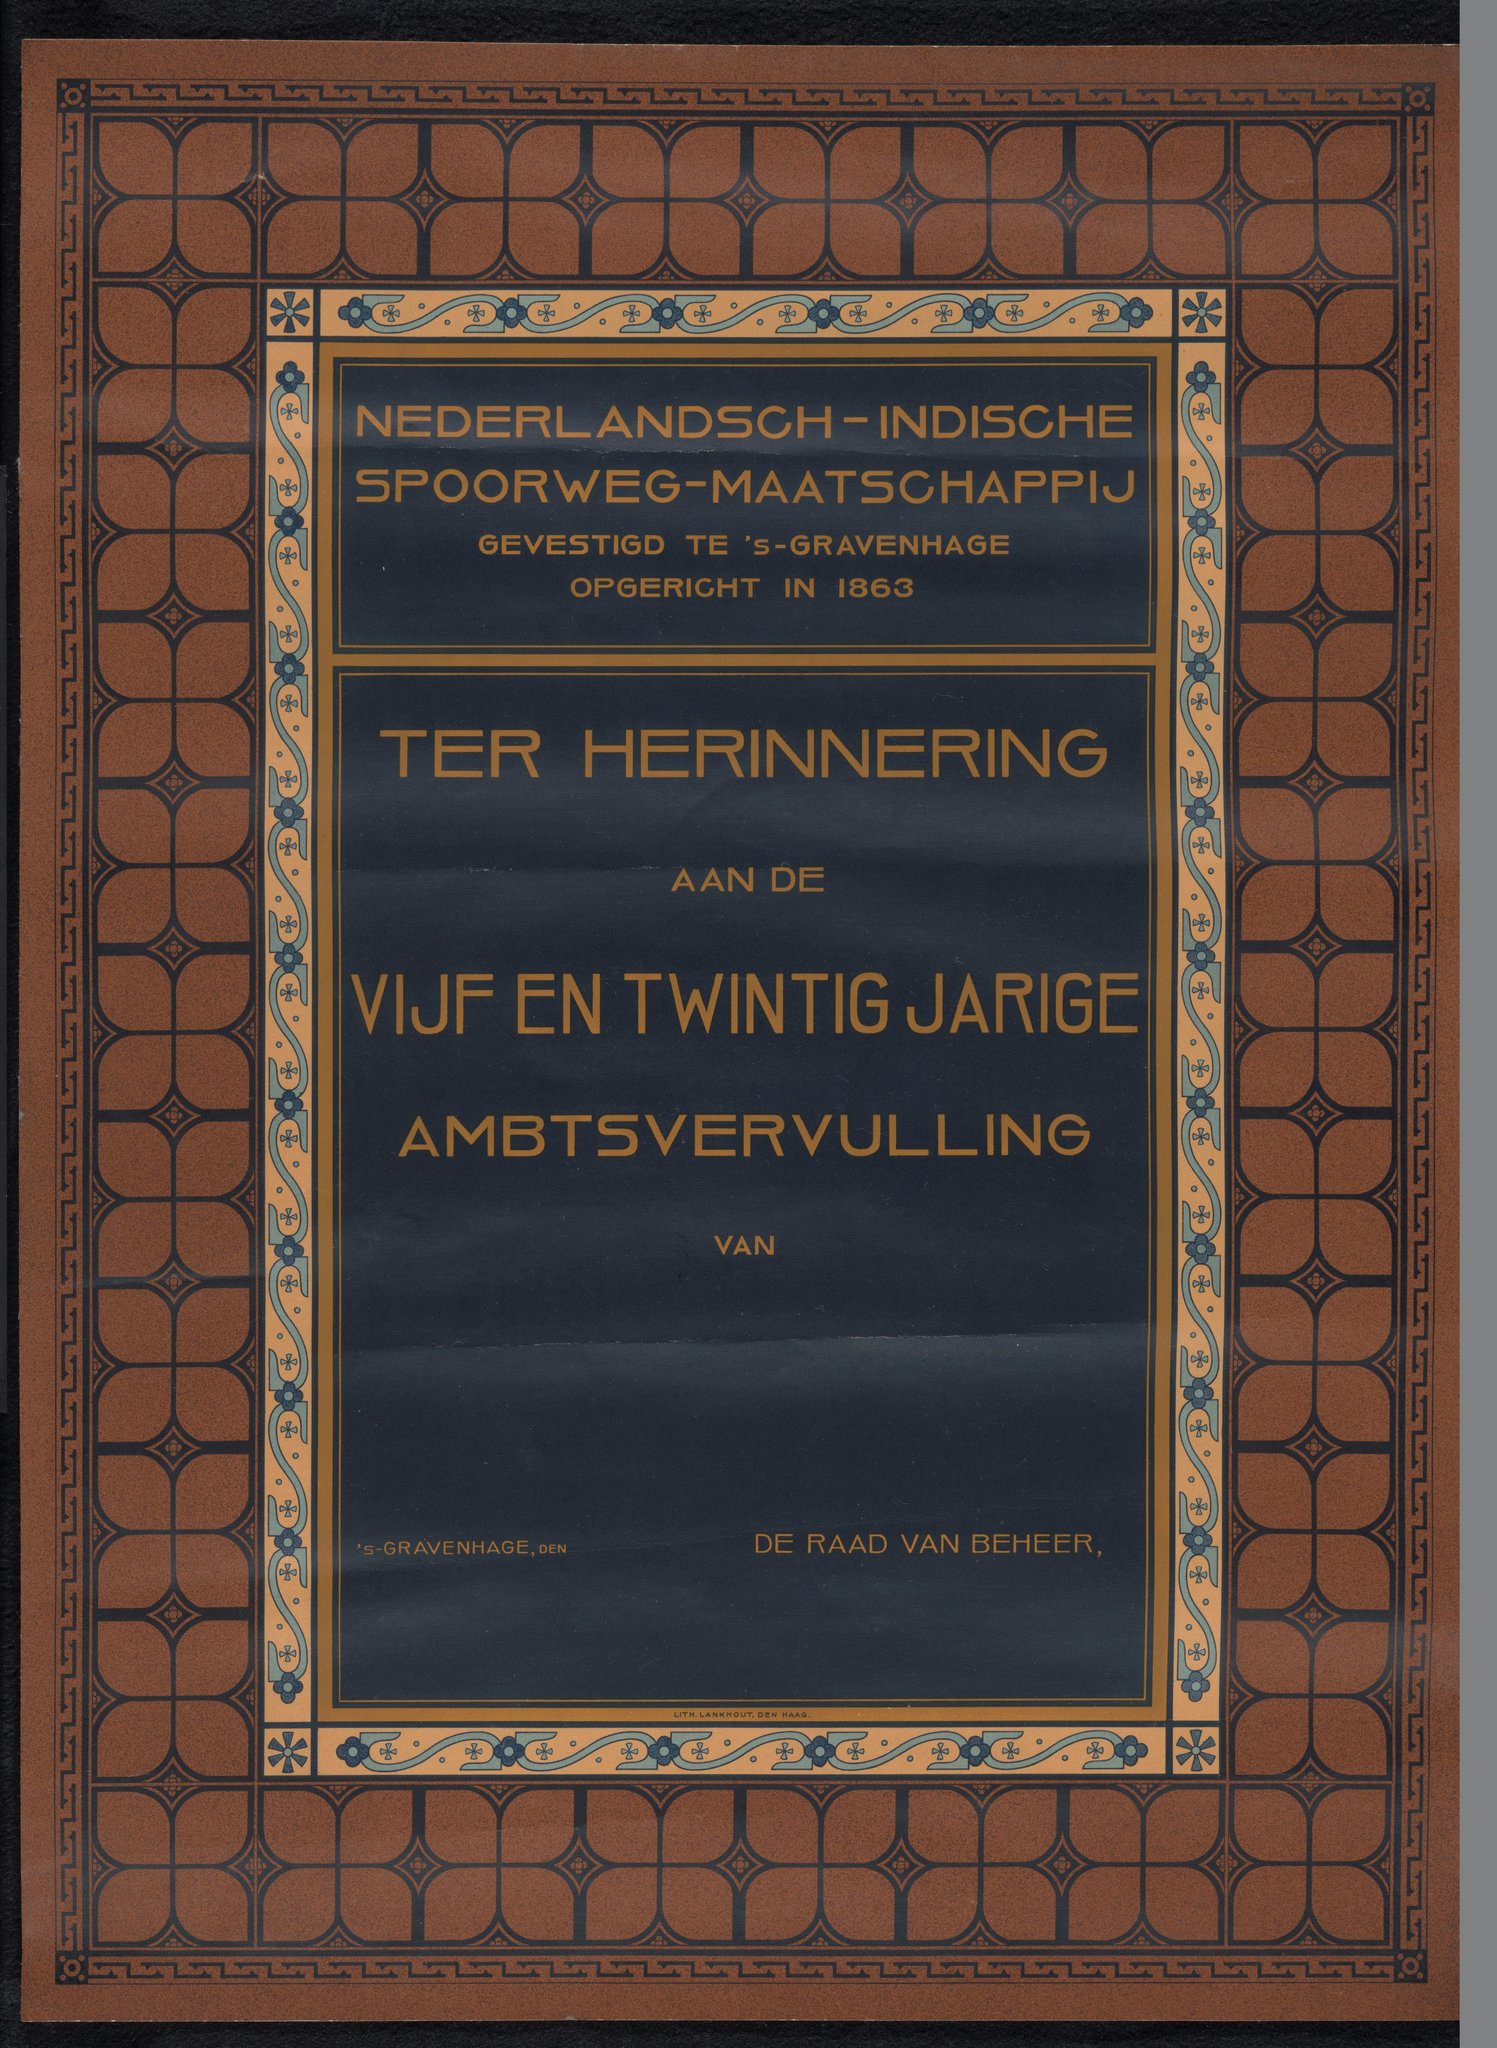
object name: charter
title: Oorkonde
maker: samuel lankhout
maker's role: print maker, printer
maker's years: 1825-1894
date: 1863-1867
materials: linen, paper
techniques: printing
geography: the hague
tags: dutch east indies, the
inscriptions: inscription: ‘NEDERLANDSCH-INDISCHE SPOORWEG-MAATSCHAPPIJ gevestigd te 's Gravenhage opgericht in 1863. Ter herinnering aan de vijf en twintigjarige ambtvervulling van 's Gravenhage, den De Raad van Beheer’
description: In 1862 werd de eerste concessie verleend voor de lijn Semarang-Vorstenlanden, twee jaar later gevolgd door een consessie voor de lijn Batavia-Buitenzorg, verleend aan de inmiddels gevormde Nederlandsch-Indische Spoorwegmaatschappij, met grote verwachtingen omtrent spooraanleg door particulier initiatief. De lijnen hadden een afwijkende spoorbreedte van 1.435 meter en een lengte van 206 kilometer.